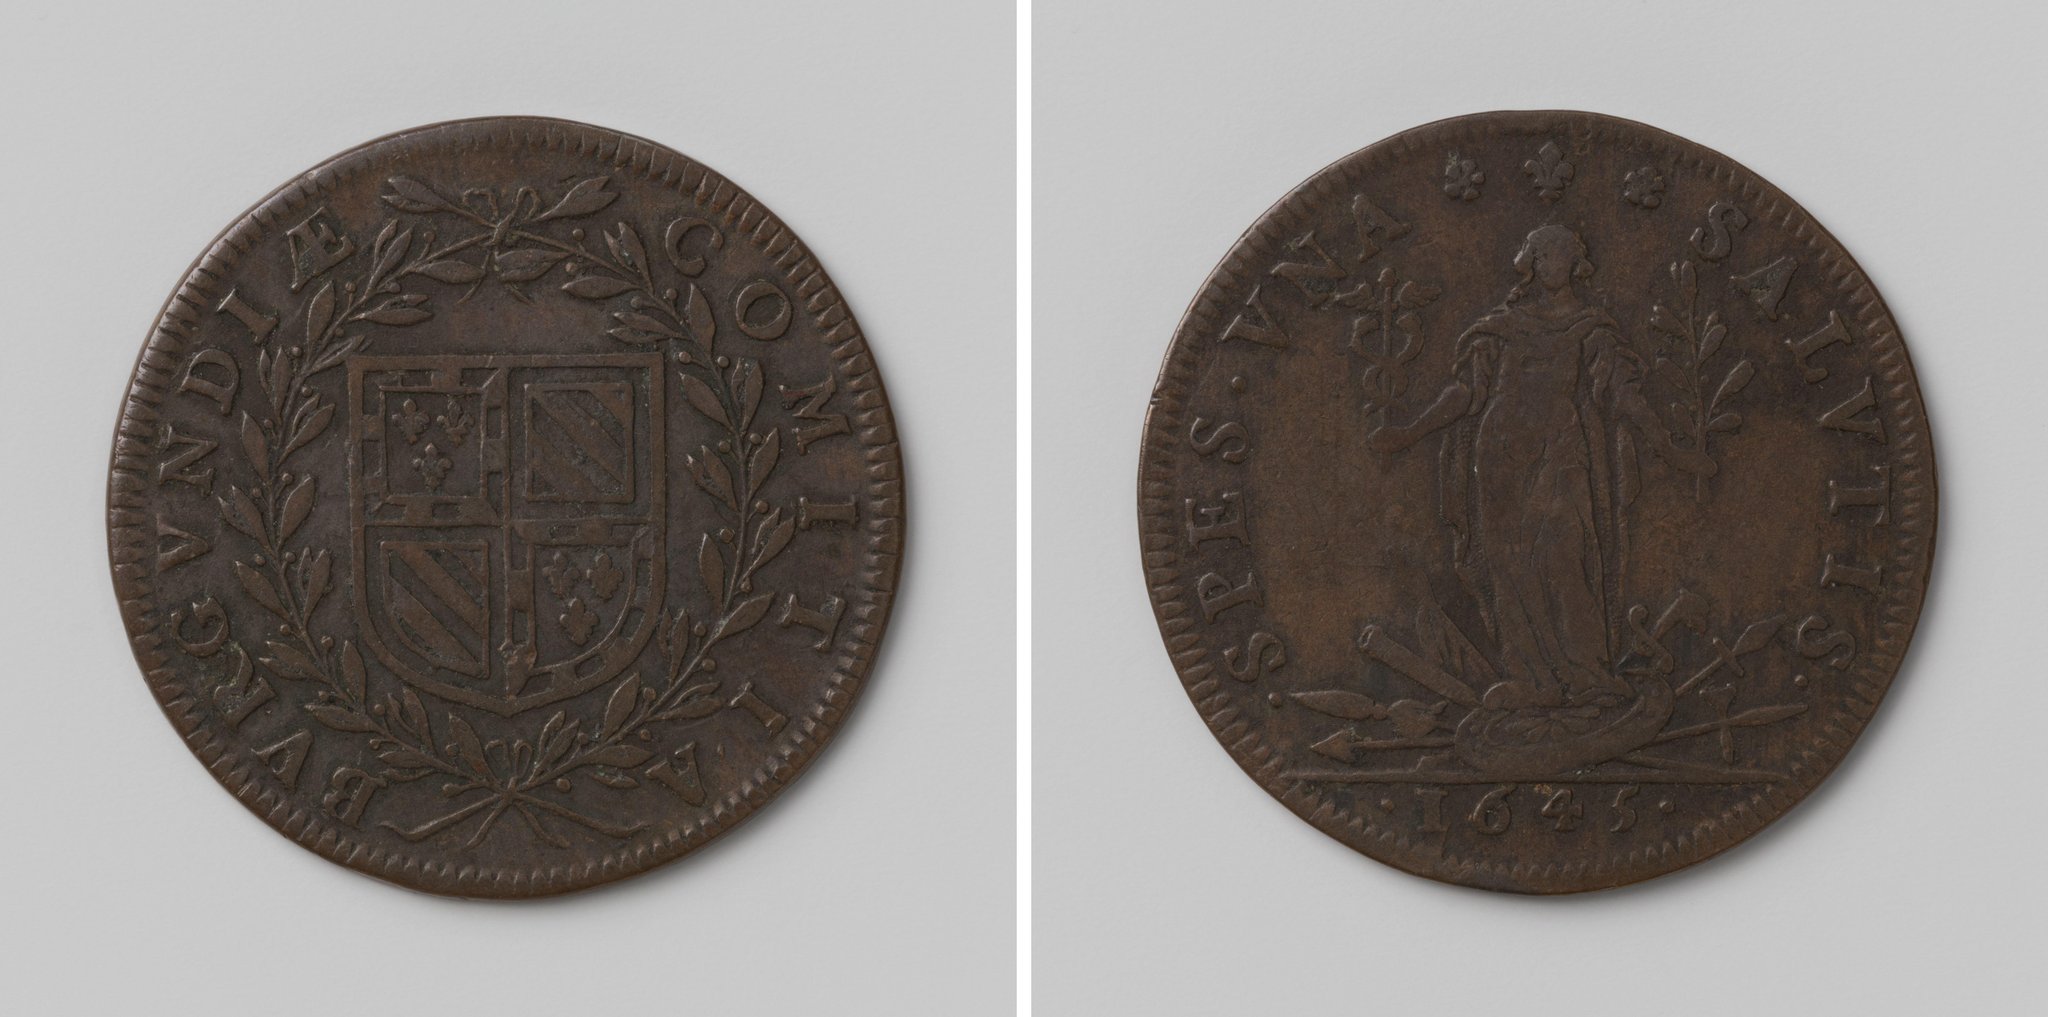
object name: jeton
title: Staten van Bourgondie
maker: Anonymous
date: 1645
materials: copper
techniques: striking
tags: staten van bourgondië, bourgondië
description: Koperen penning. Voorzijde: wapenschild binnen lauwerkrans en omschrift. Keerzijde: vrouw met palmtak in linker- en Mercuriusstaf in rechterhand, staande op stapel wapentuig binnen omschrift; afsnede: jaartal